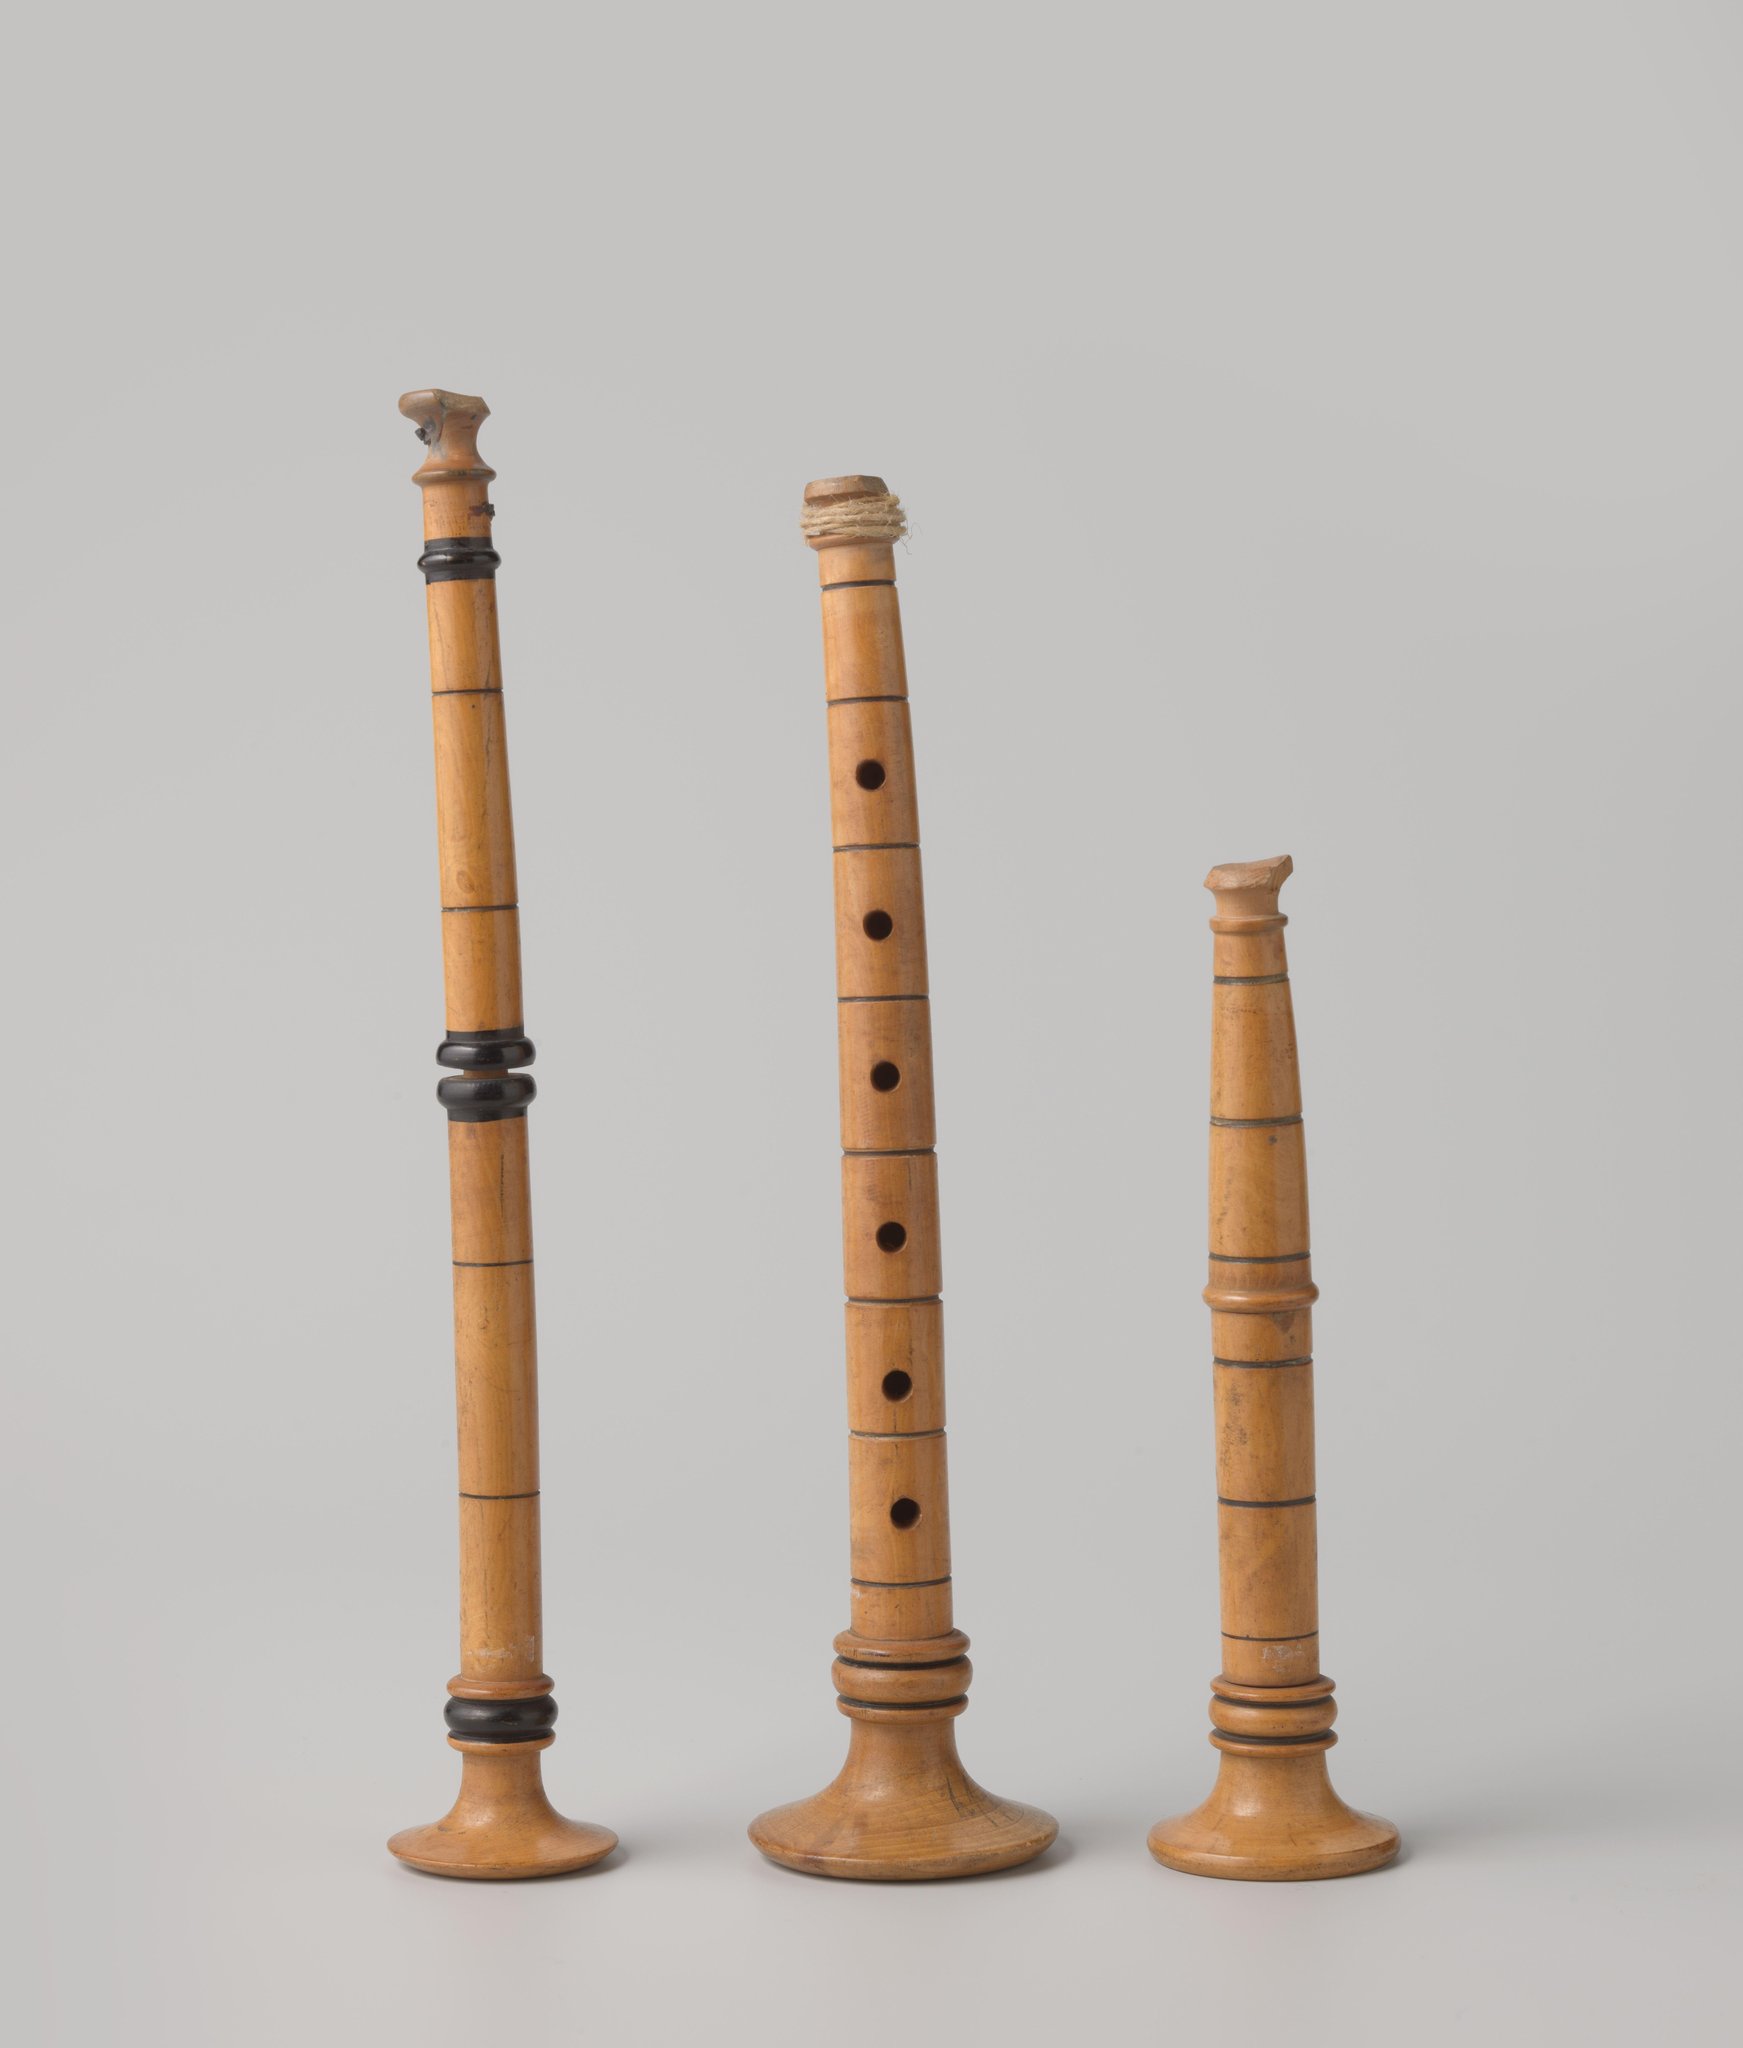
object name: toy bagpipe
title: Toy bagpipe (three chanters)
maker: Anonymous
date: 1850-1896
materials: wood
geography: england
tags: bagpipe, musette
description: Drie pijpen van een speelgoed doedelzak. De zak mist